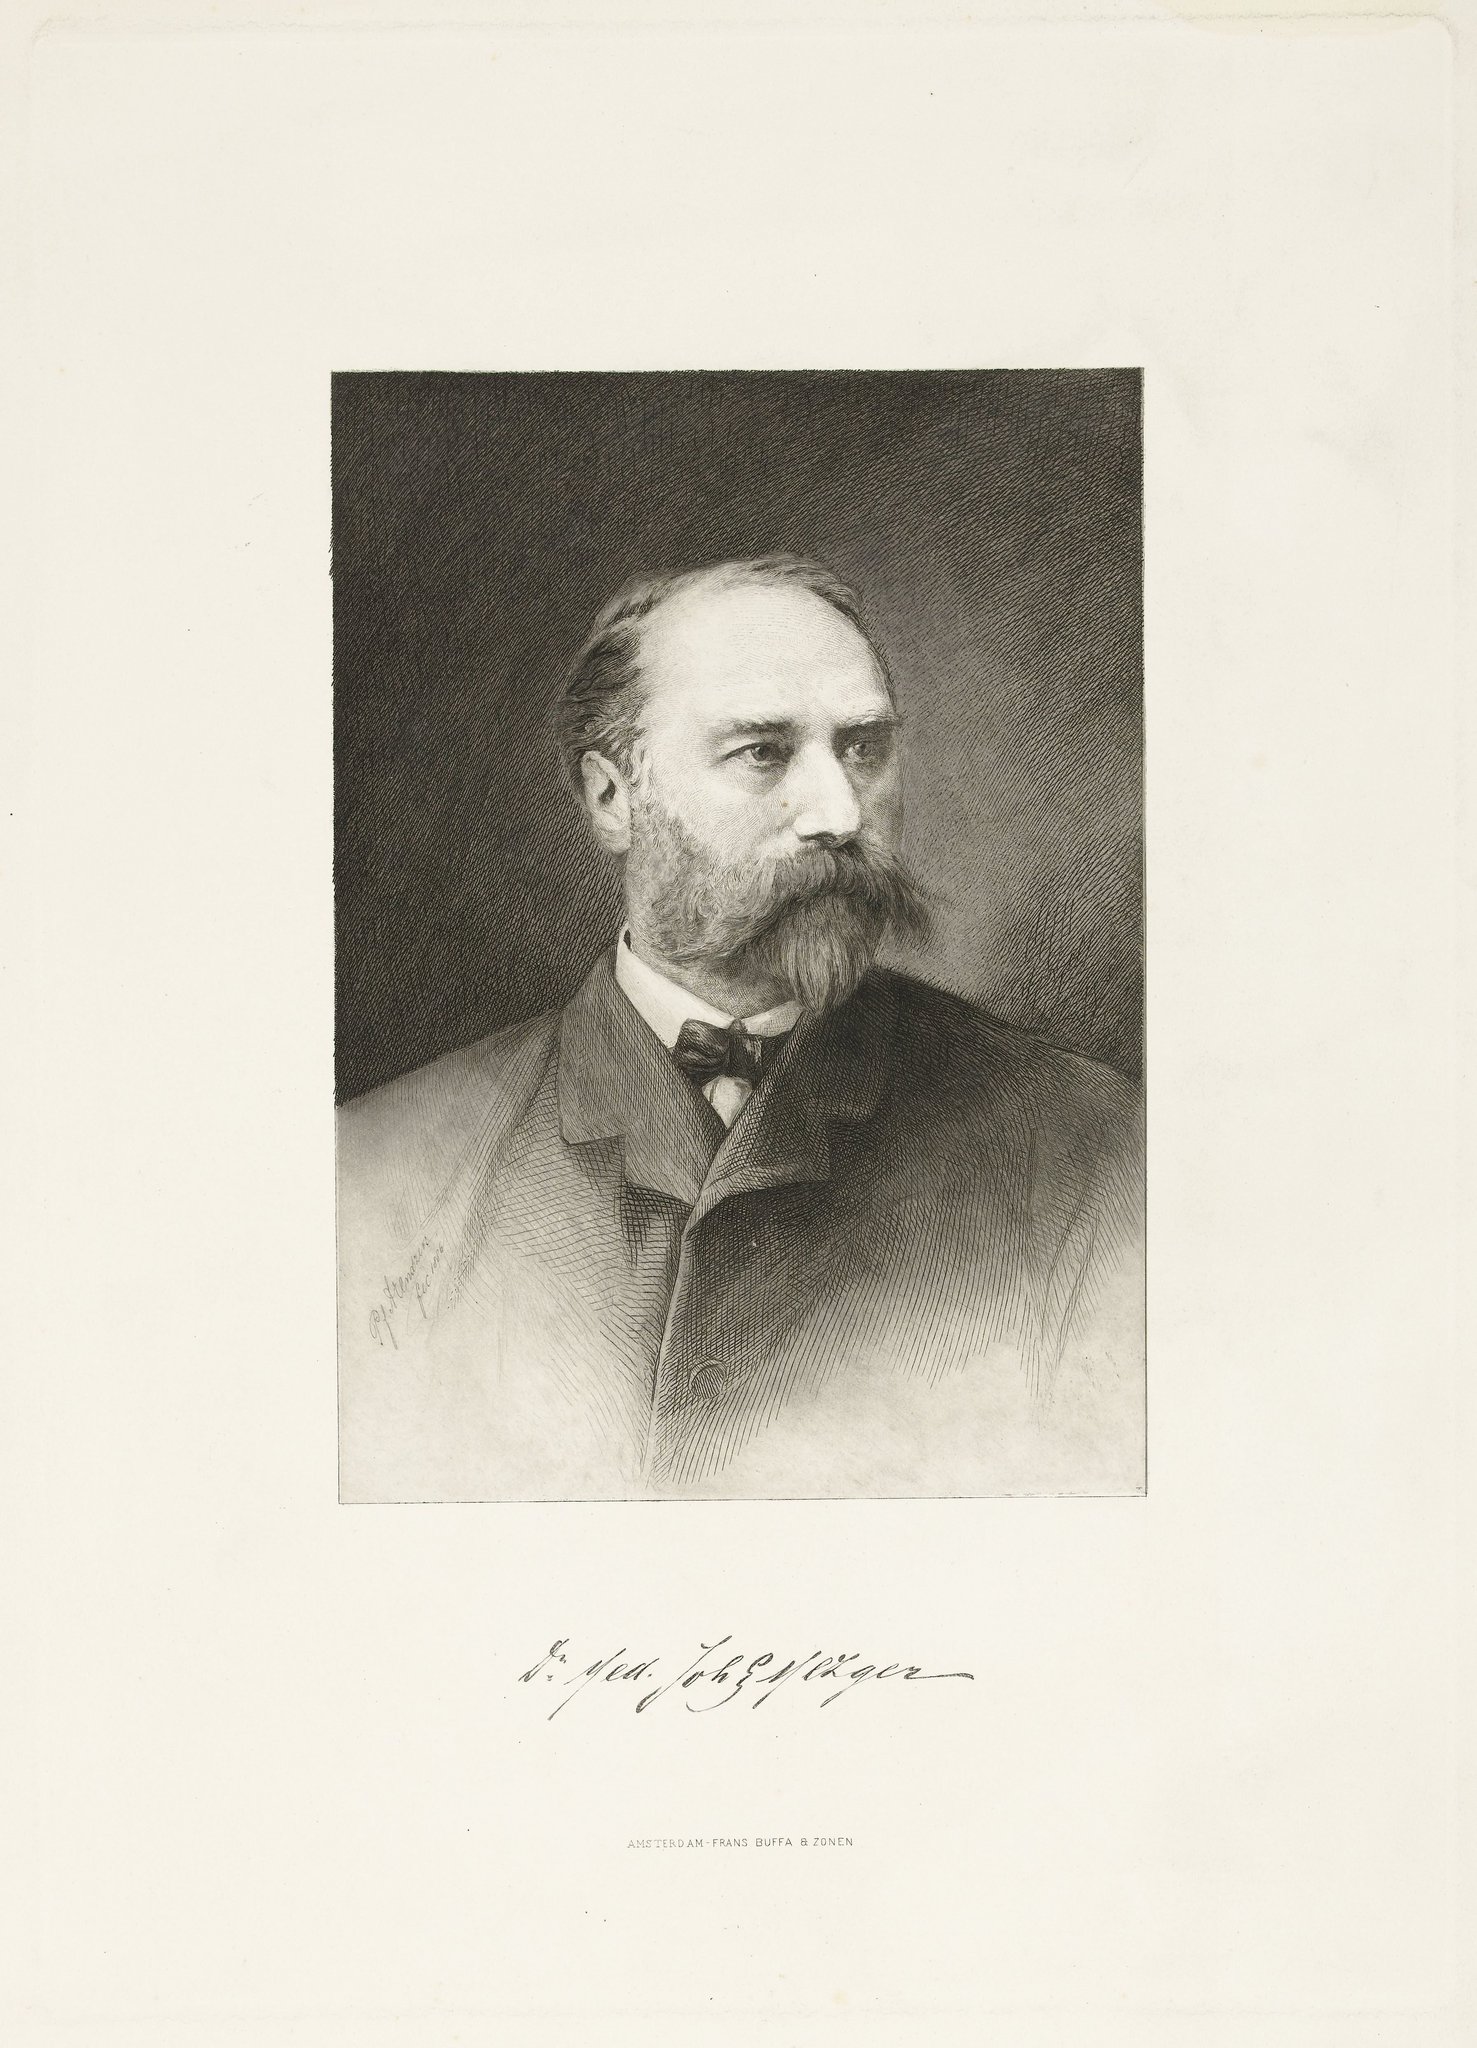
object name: print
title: Portret van de arts Johann Georg Mezger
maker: petrus johannes arendzen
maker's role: draughtsman, print maker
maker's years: 1846-1932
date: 1886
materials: paper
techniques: aquatint, etching, roulette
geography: netherlands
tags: amsterdam, paris, physician, doctor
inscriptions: collector's mark: Lugt 2228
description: Portret van de bekende arts en grondlegger van de fysiotherapie Johann Georg Mezger. Onder het portret Mezgers handtekening in facsimile.